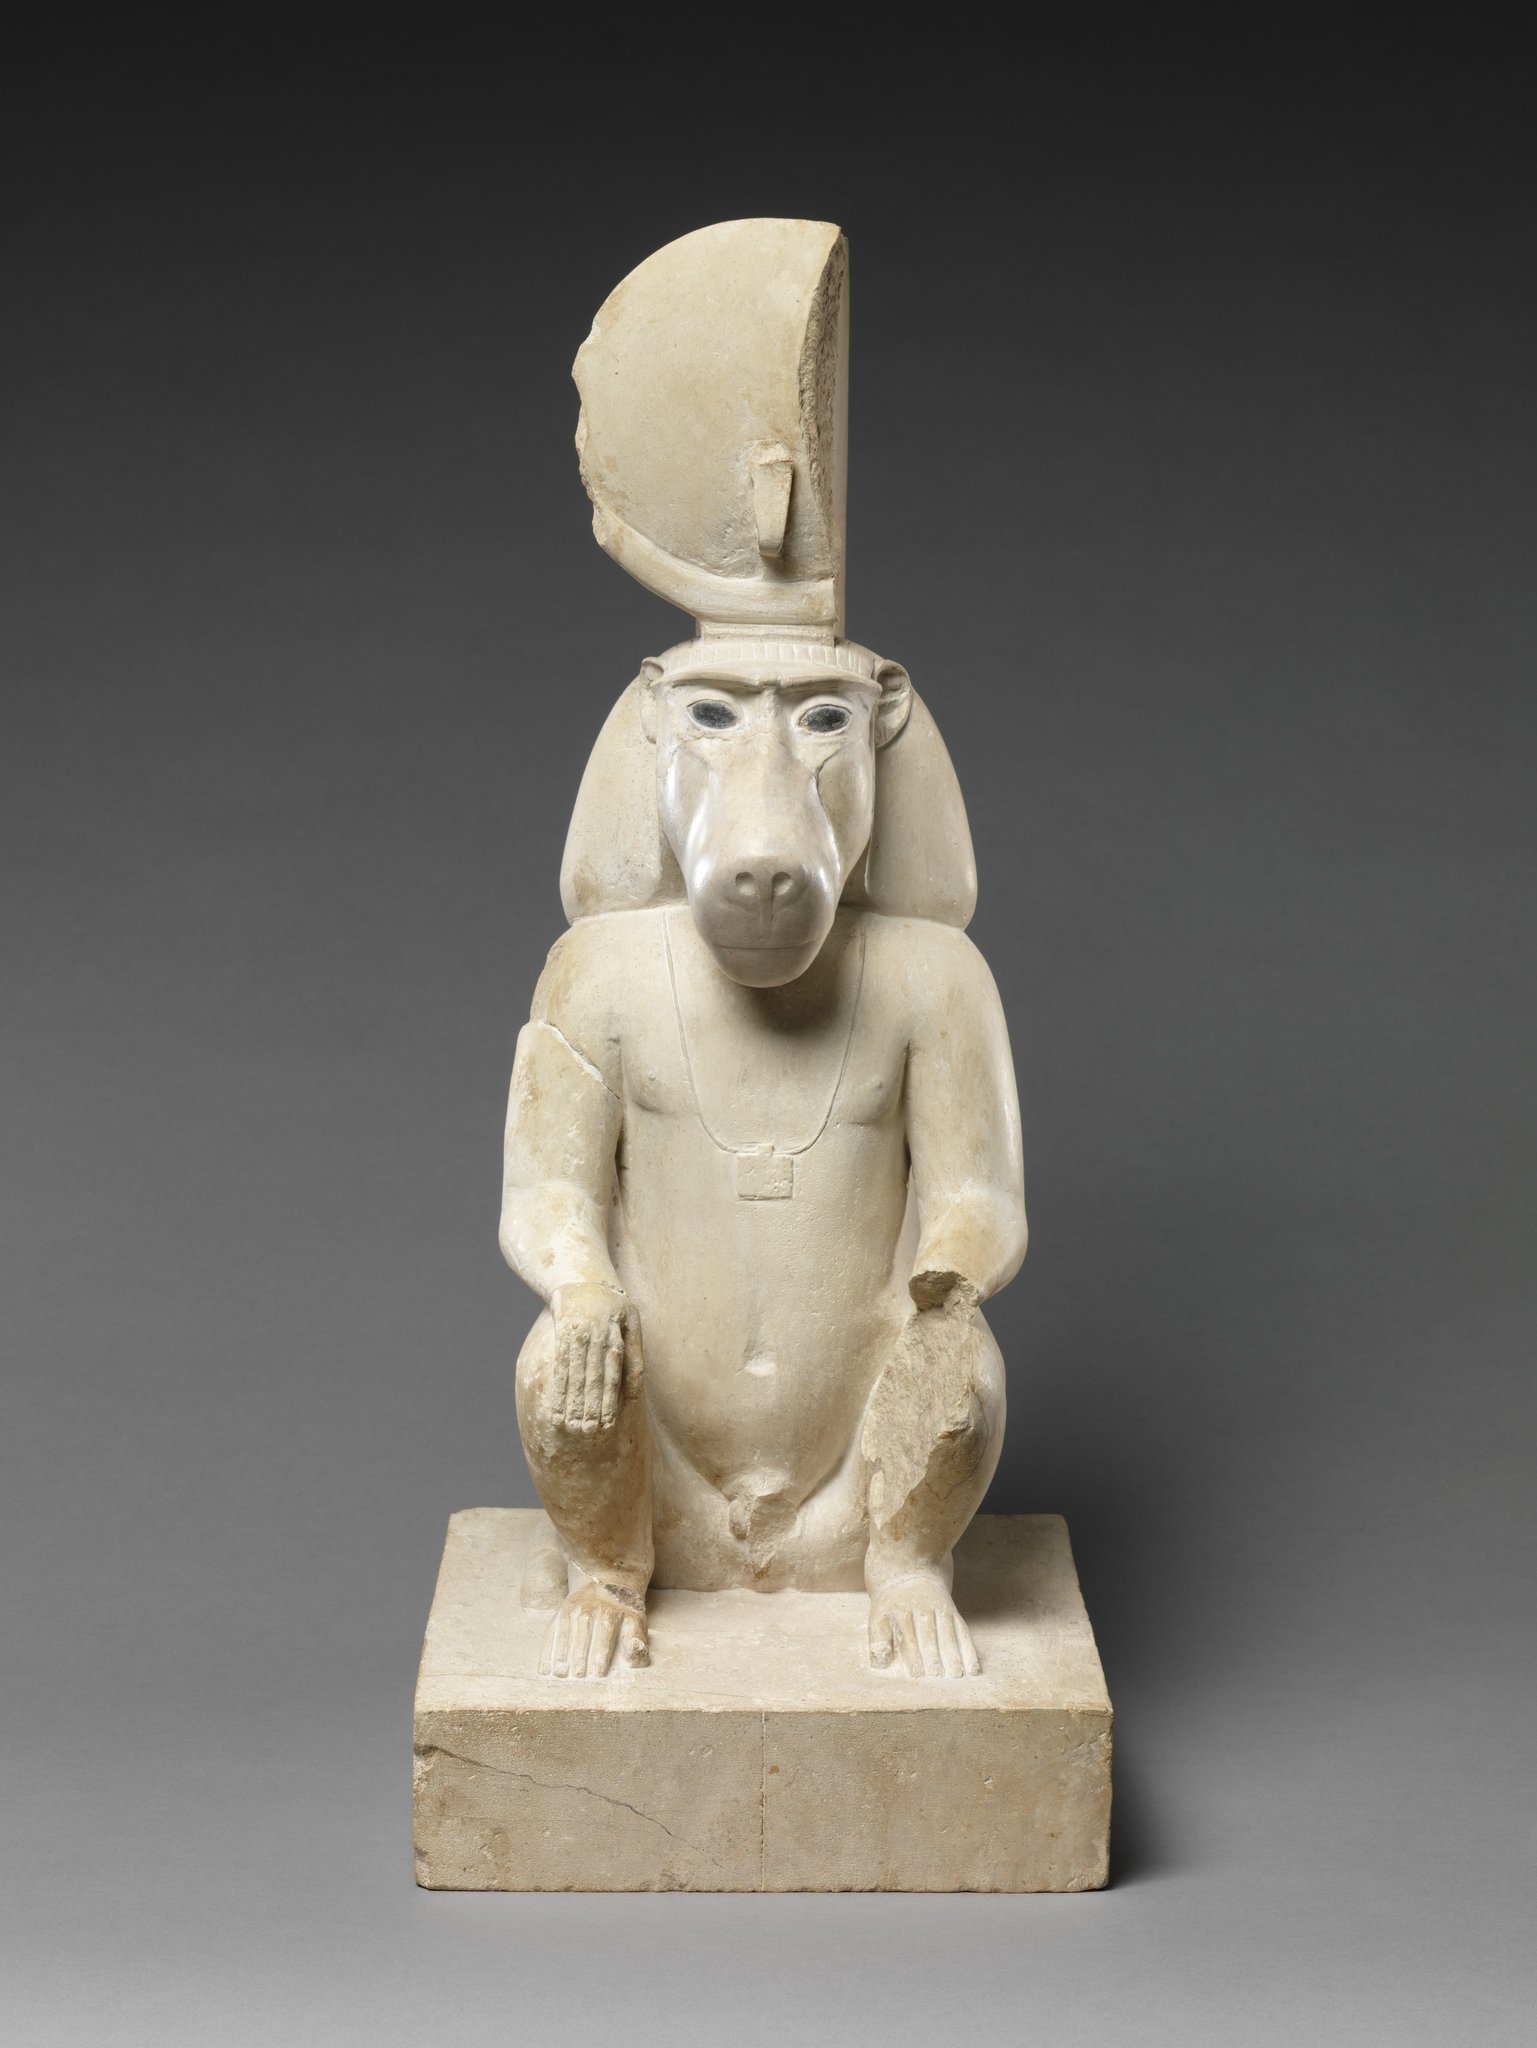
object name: statue, baboon seated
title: Statue of a seated baboon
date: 400-301 BCE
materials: limestone, paint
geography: egypt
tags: baboons